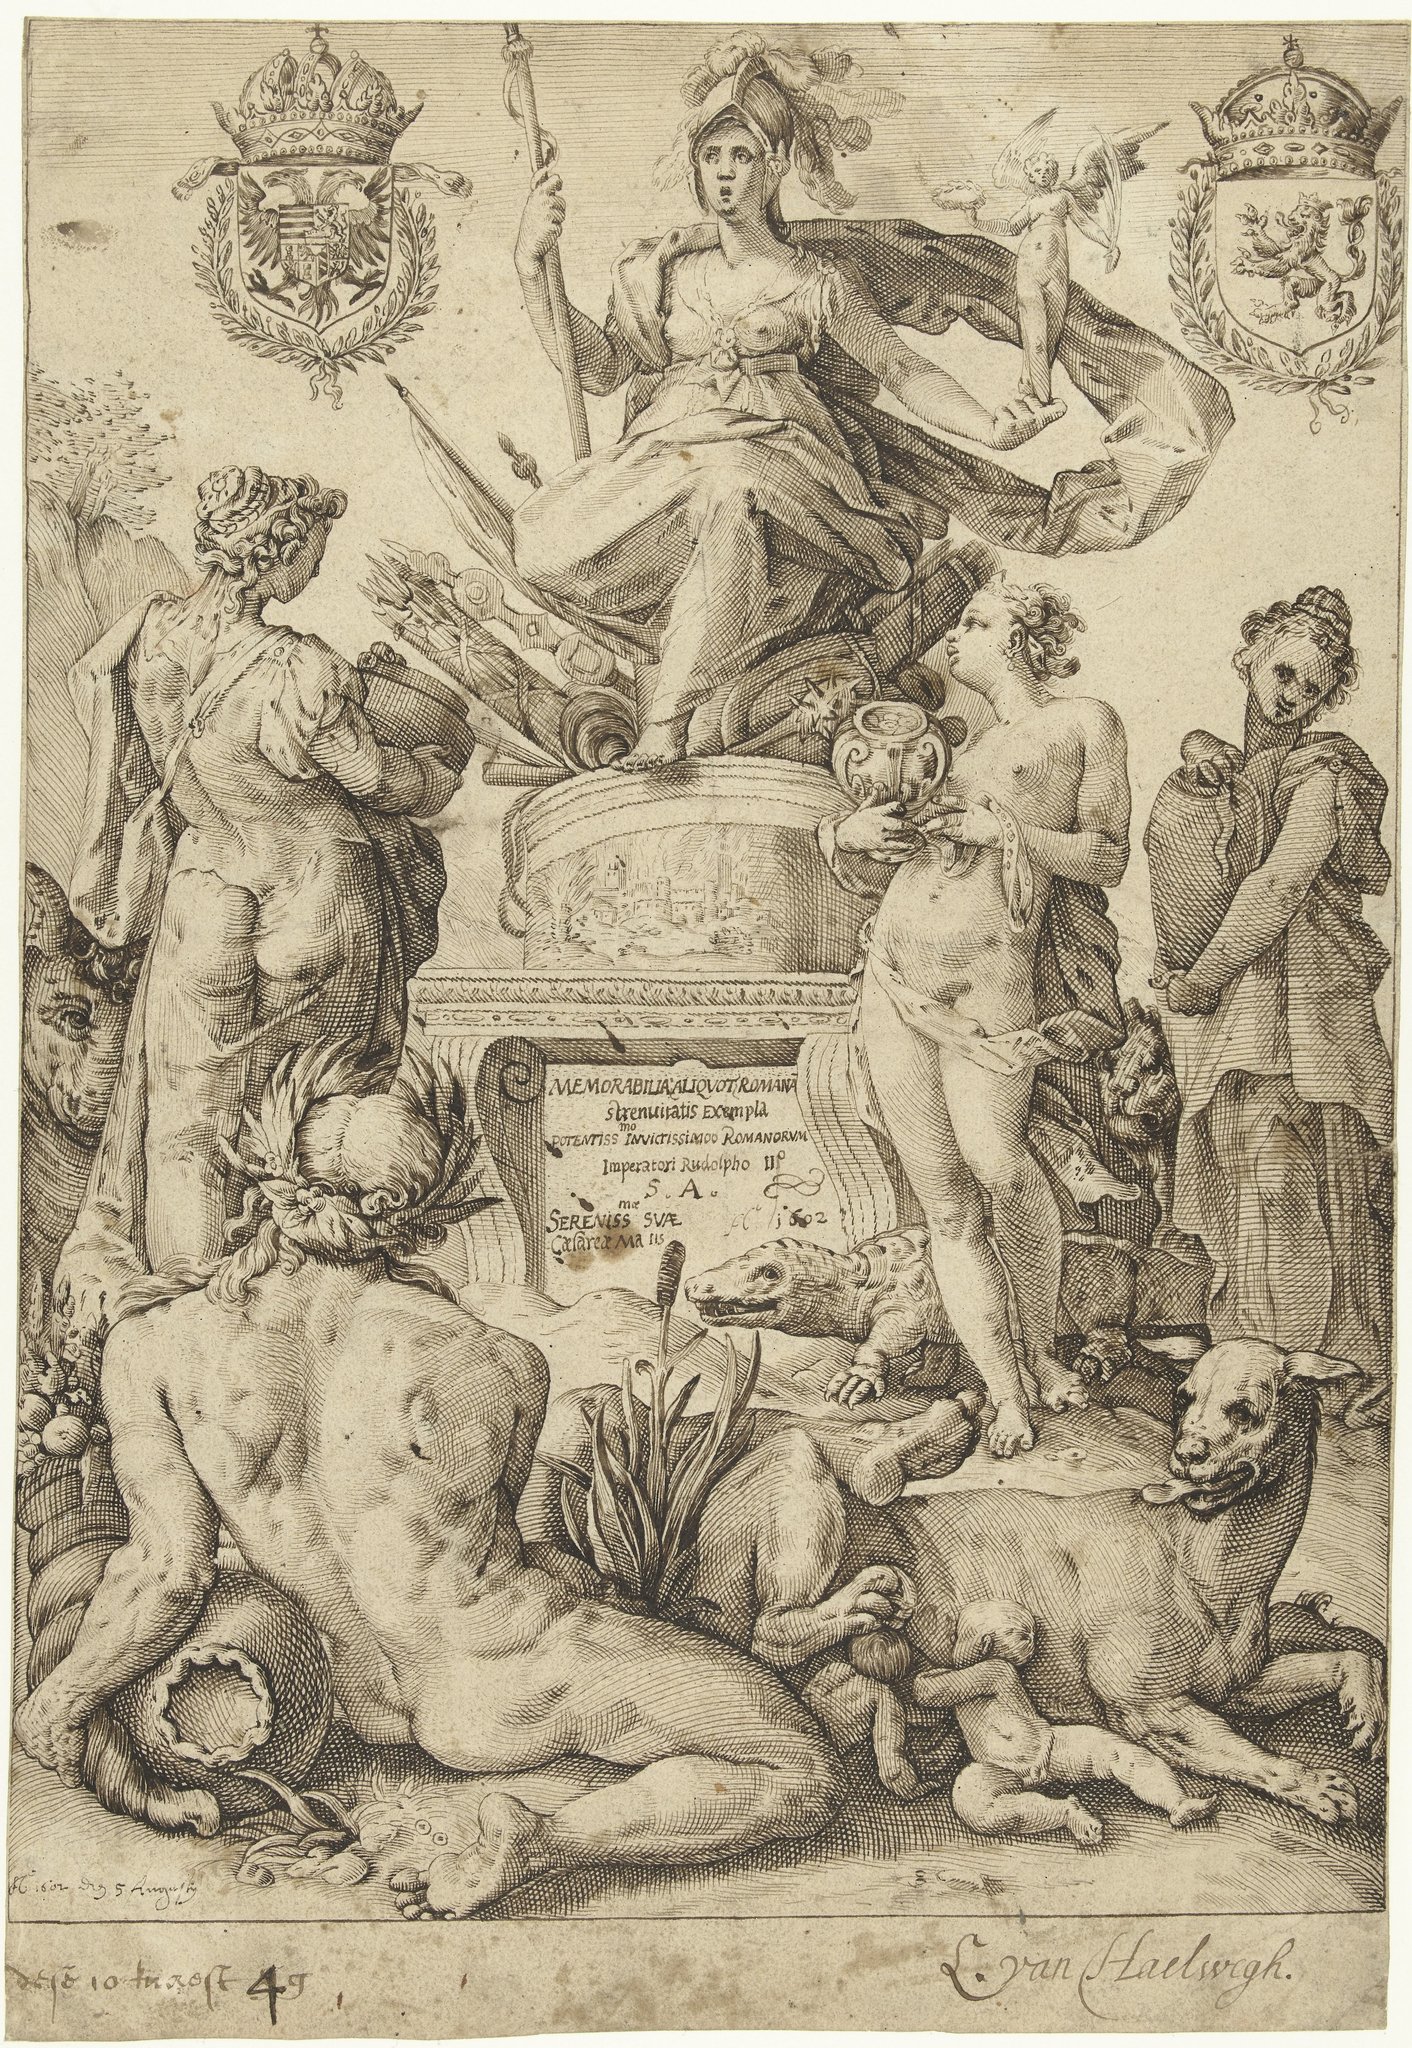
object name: drawing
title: Titelblad: Romeinse Helden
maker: lucas van haelwech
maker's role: draughtsman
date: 1602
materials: ink, paper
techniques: pen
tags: europe represented allegorically; 'europa' (ripa), asia represented allegorically; 'asia' (ripa), africa represented allegorically; 'africa' (ripa), personification of a city, town-patron(ess), romulus and remus are washed ashore and suckled by a she-wolf; 'lupa romana', rome (one of the four world empires)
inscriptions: date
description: Titelblad uit serie van tien bladen met Romeinse Helden naar Hendrick Goltzius.